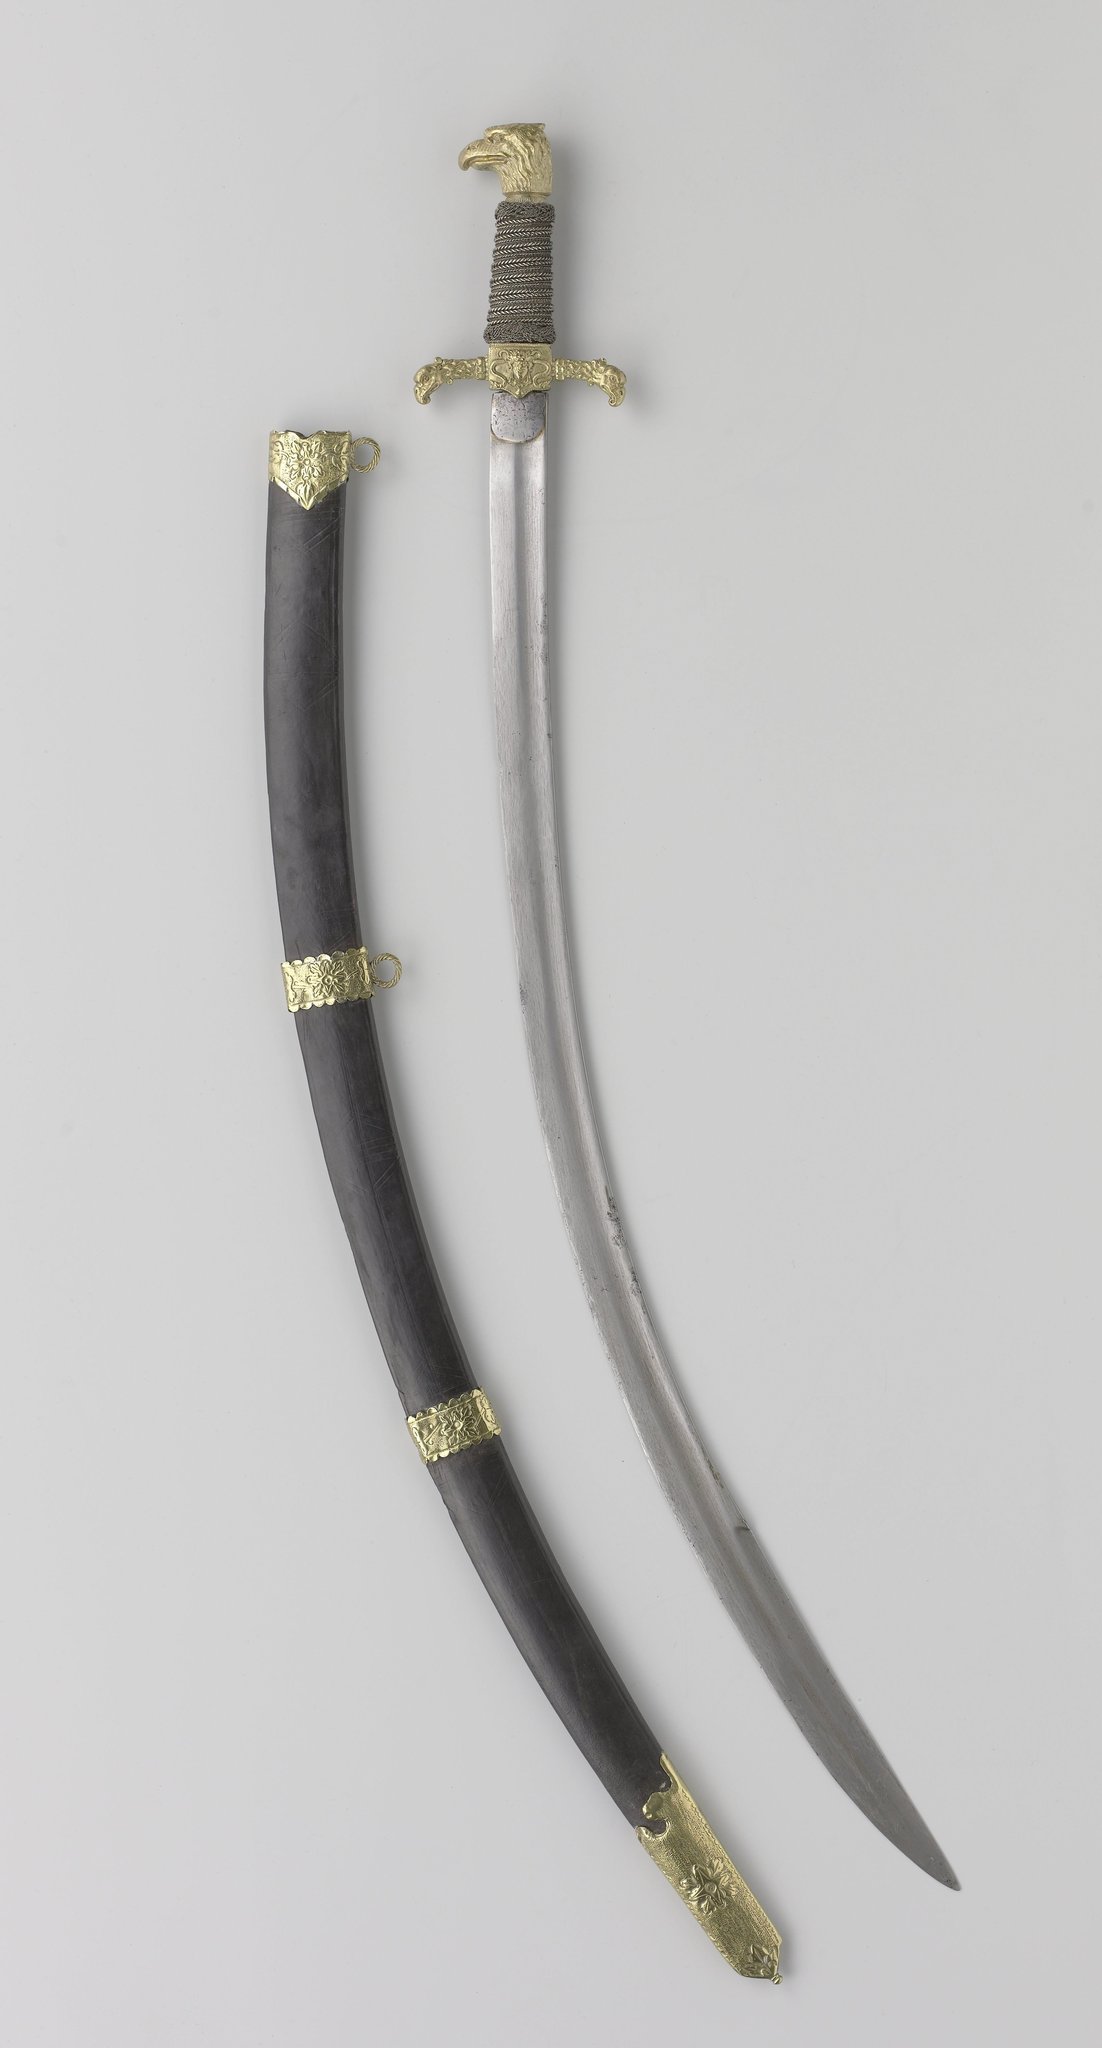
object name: sabre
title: Sabel van Cornelis Tromp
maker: Anonymous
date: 1650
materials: copper, thread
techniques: braiding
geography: iran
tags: rotterdam, amsterdam, cornelis tromp, predatory birds: eagle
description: Arms collection of Cornelis Tromp. These weapons were kept at the Amsterdam home of Cornelis Tromp. The collection included contemporary weapons of exceptional quality and several exotic weapons acquired for their curiosity value. Tromp probably received many of these weapons as gifts during his patrols of the Mediterranean Sea and in the Baltic.